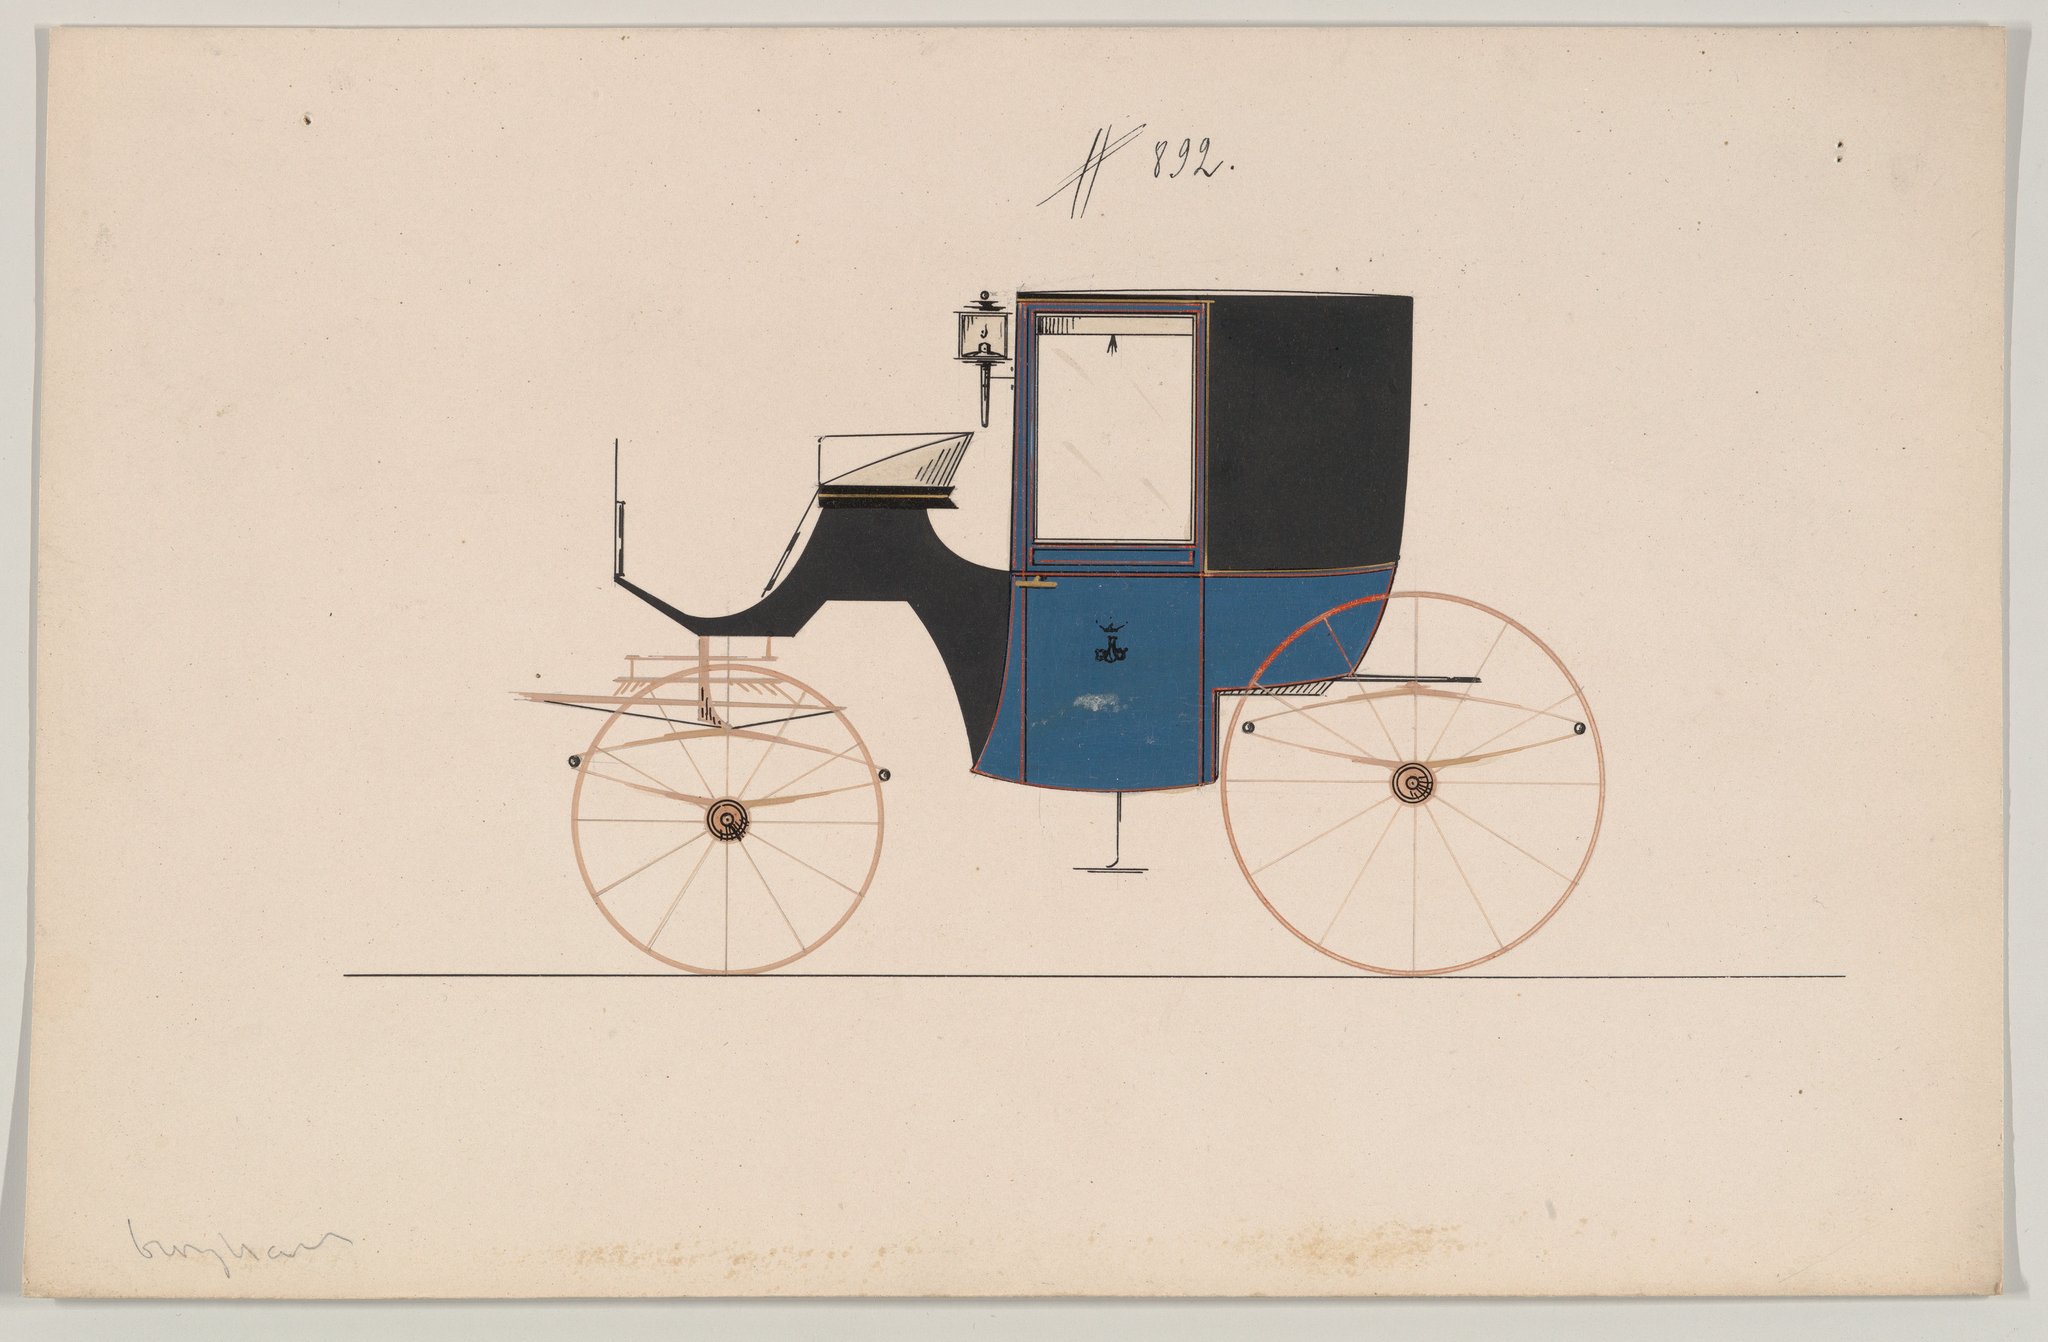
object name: drawing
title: Brougham #892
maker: brewster & co.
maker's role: manufacturer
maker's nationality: american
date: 1850-1870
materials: gouache, gum arabic, watercolor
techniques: pen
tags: carriages